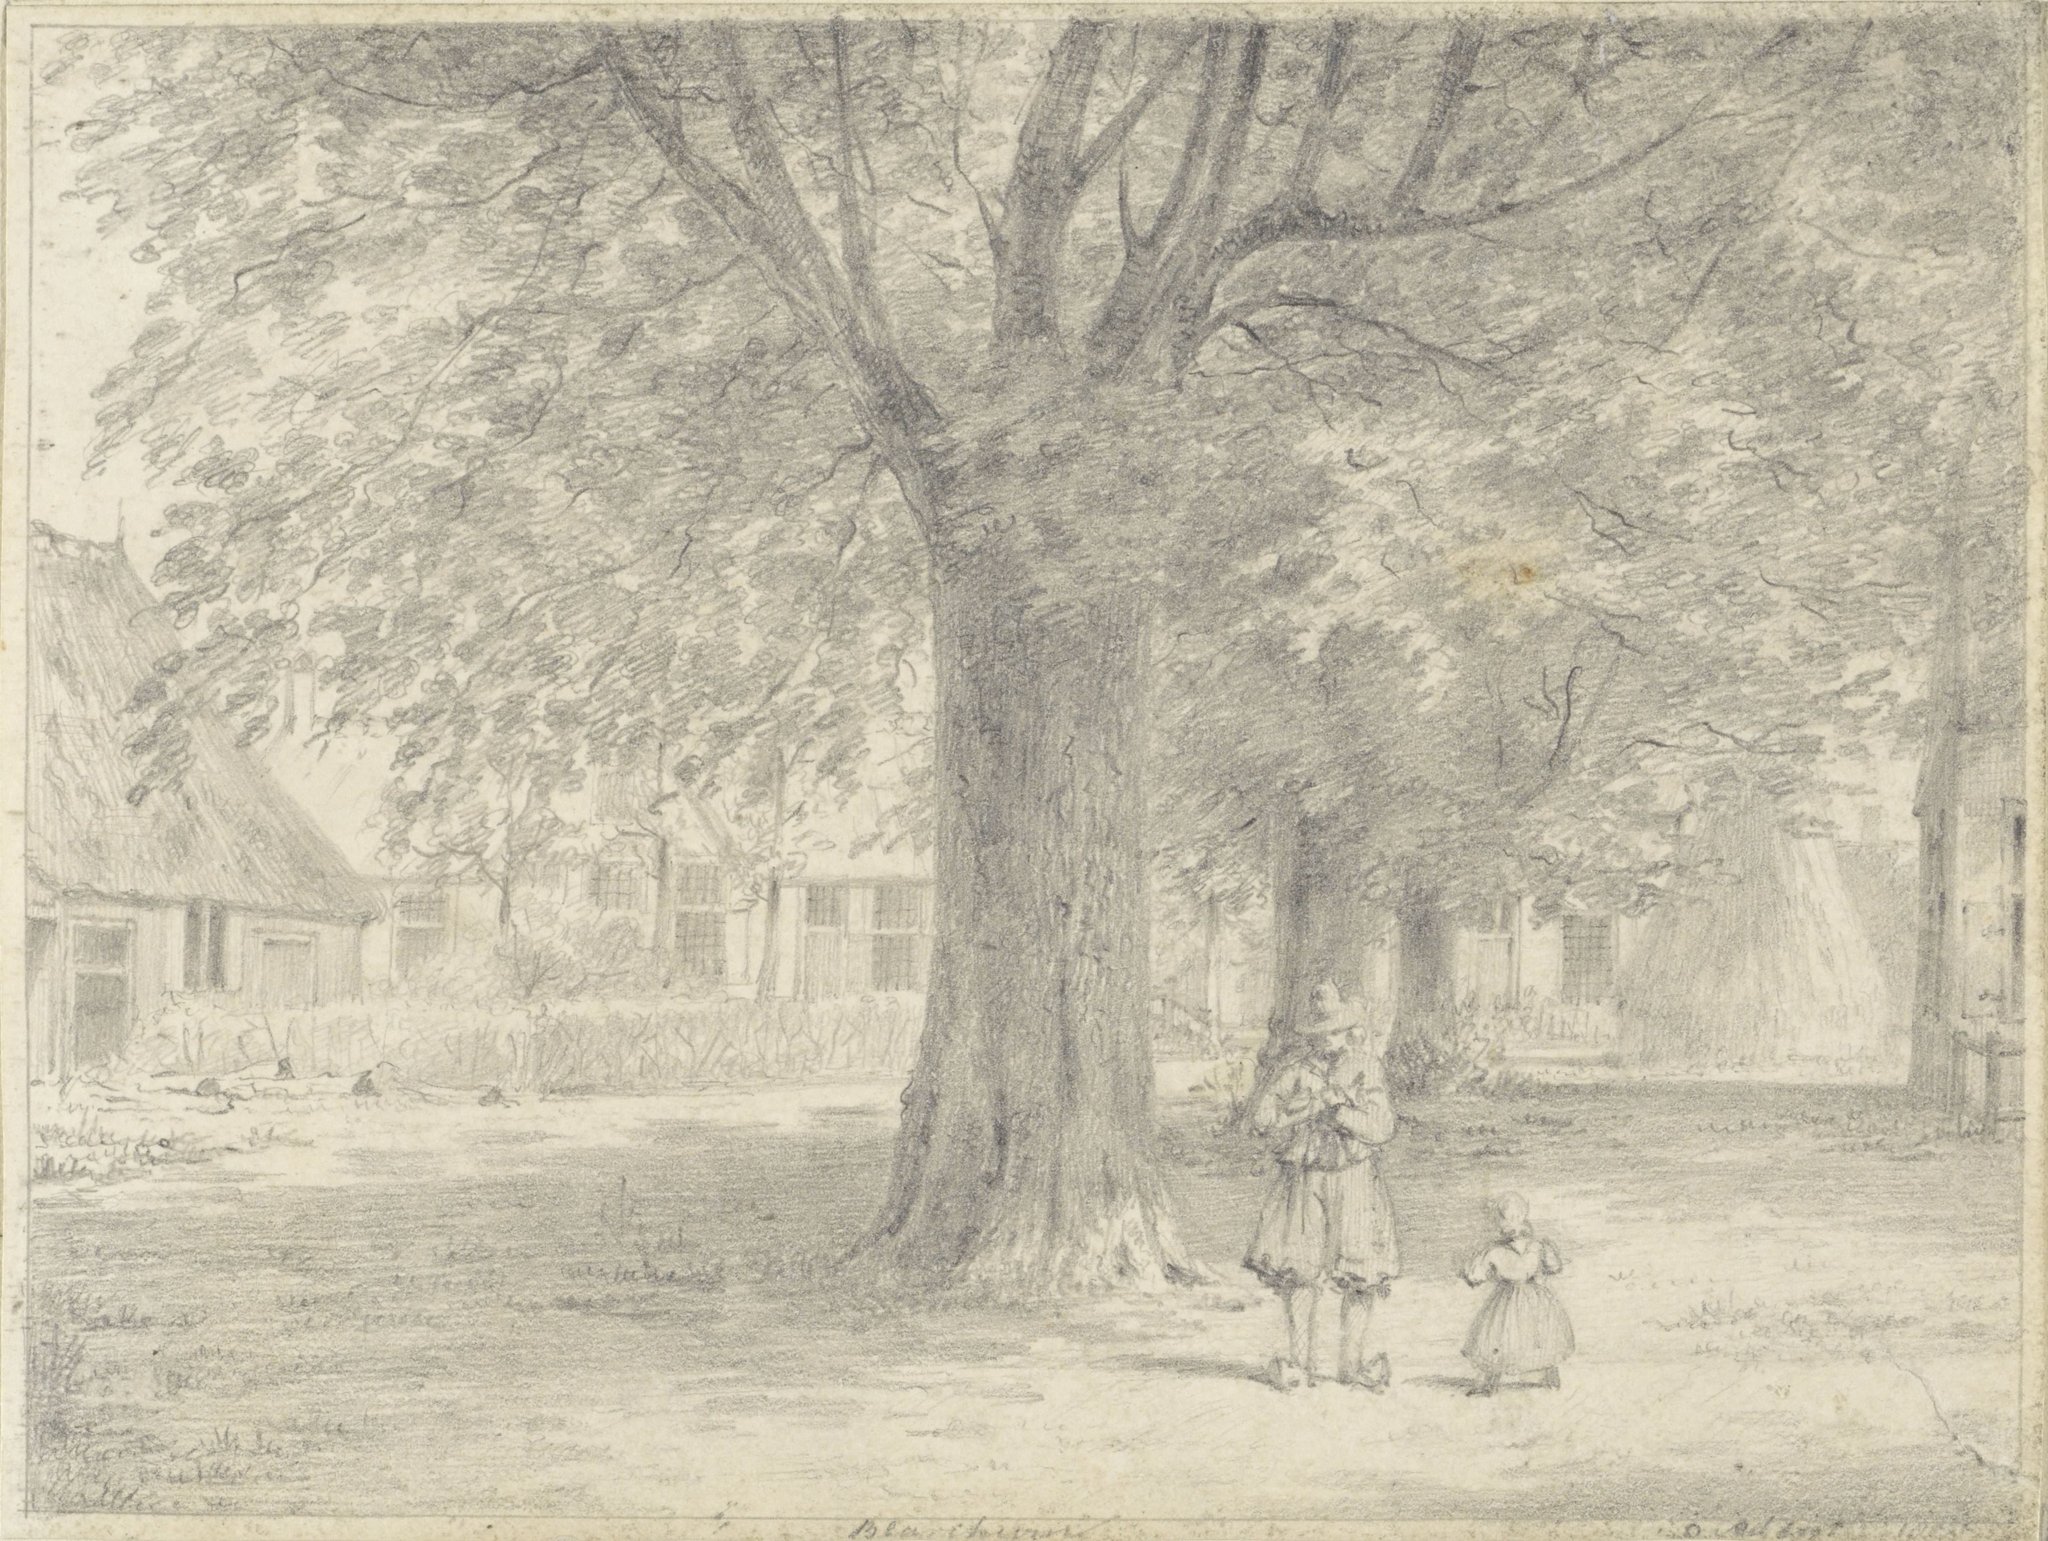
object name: drawing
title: Het plein van Blaricum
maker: hendrik abraham klinkhamer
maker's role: draughtsman, painter, print maker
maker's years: 1810-1872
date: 1839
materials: paper, pencil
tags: street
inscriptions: inscription: ‘het pleyn van blarikum uit de Herberg genomen’